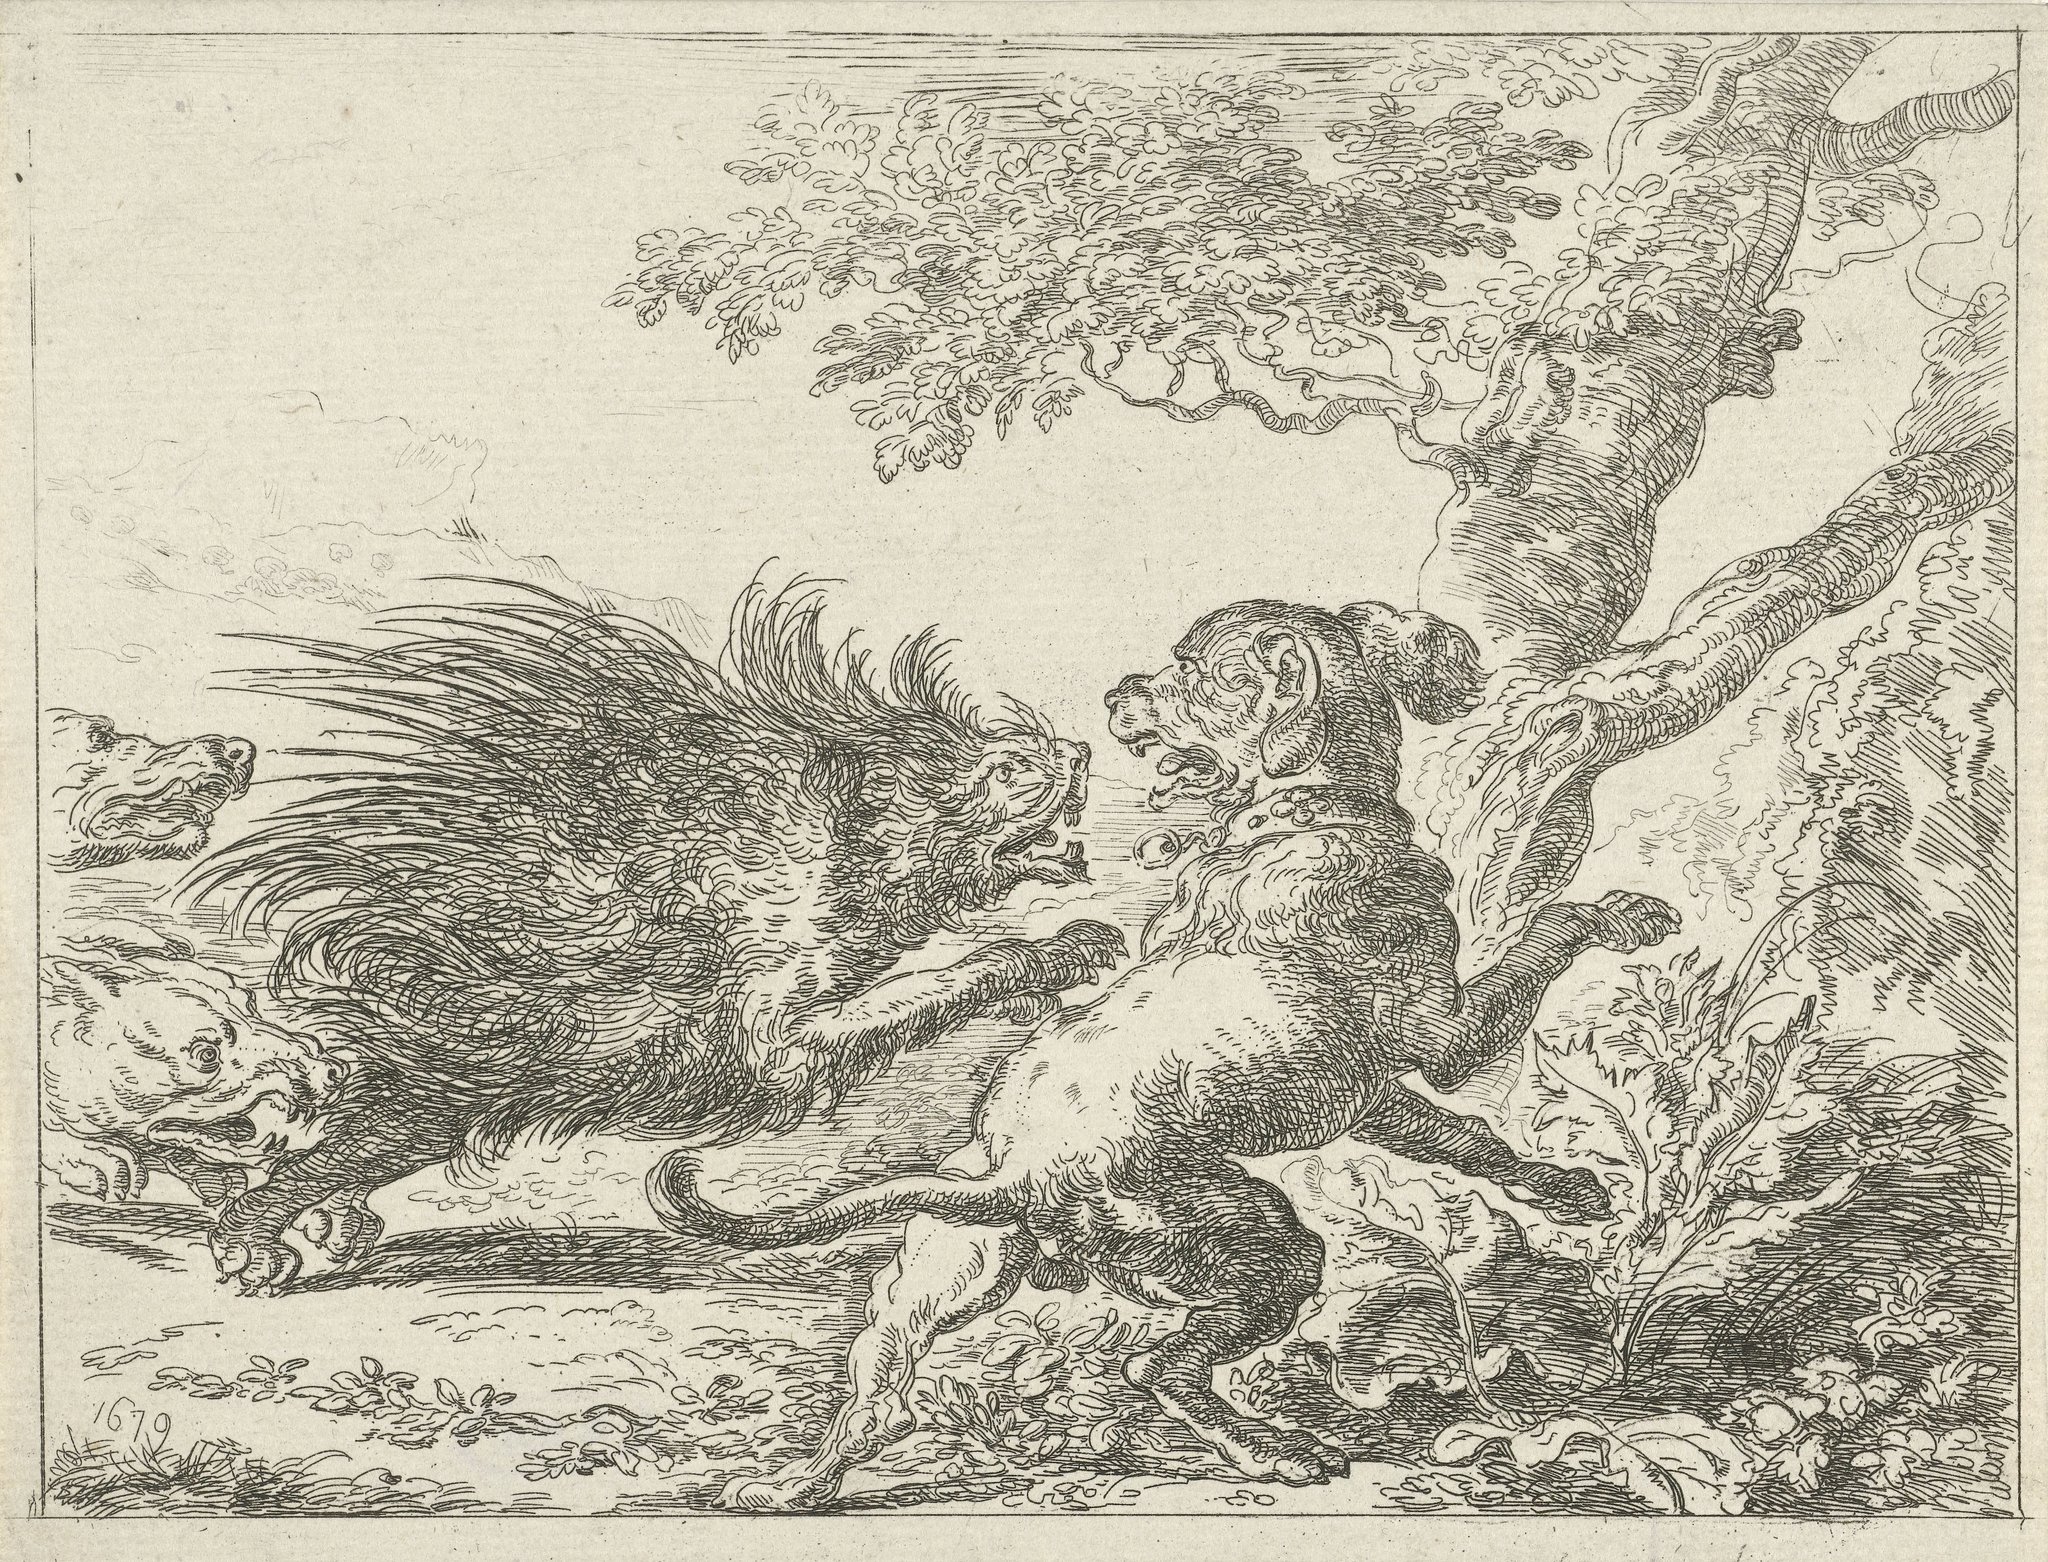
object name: print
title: Stekelvarken door honden aangevallen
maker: Anonymous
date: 1679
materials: paper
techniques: etching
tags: other mammals: porcupine, hunter, animals (+ fighting animals; aggressive relations), dog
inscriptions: collector's mark: Lugt 2228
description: Een stekelvarken wordt door honden aangevallen. Kopie naar een prent uit een serie prenten met jagende dieren van Abraham Daniëlsz. Hondius.